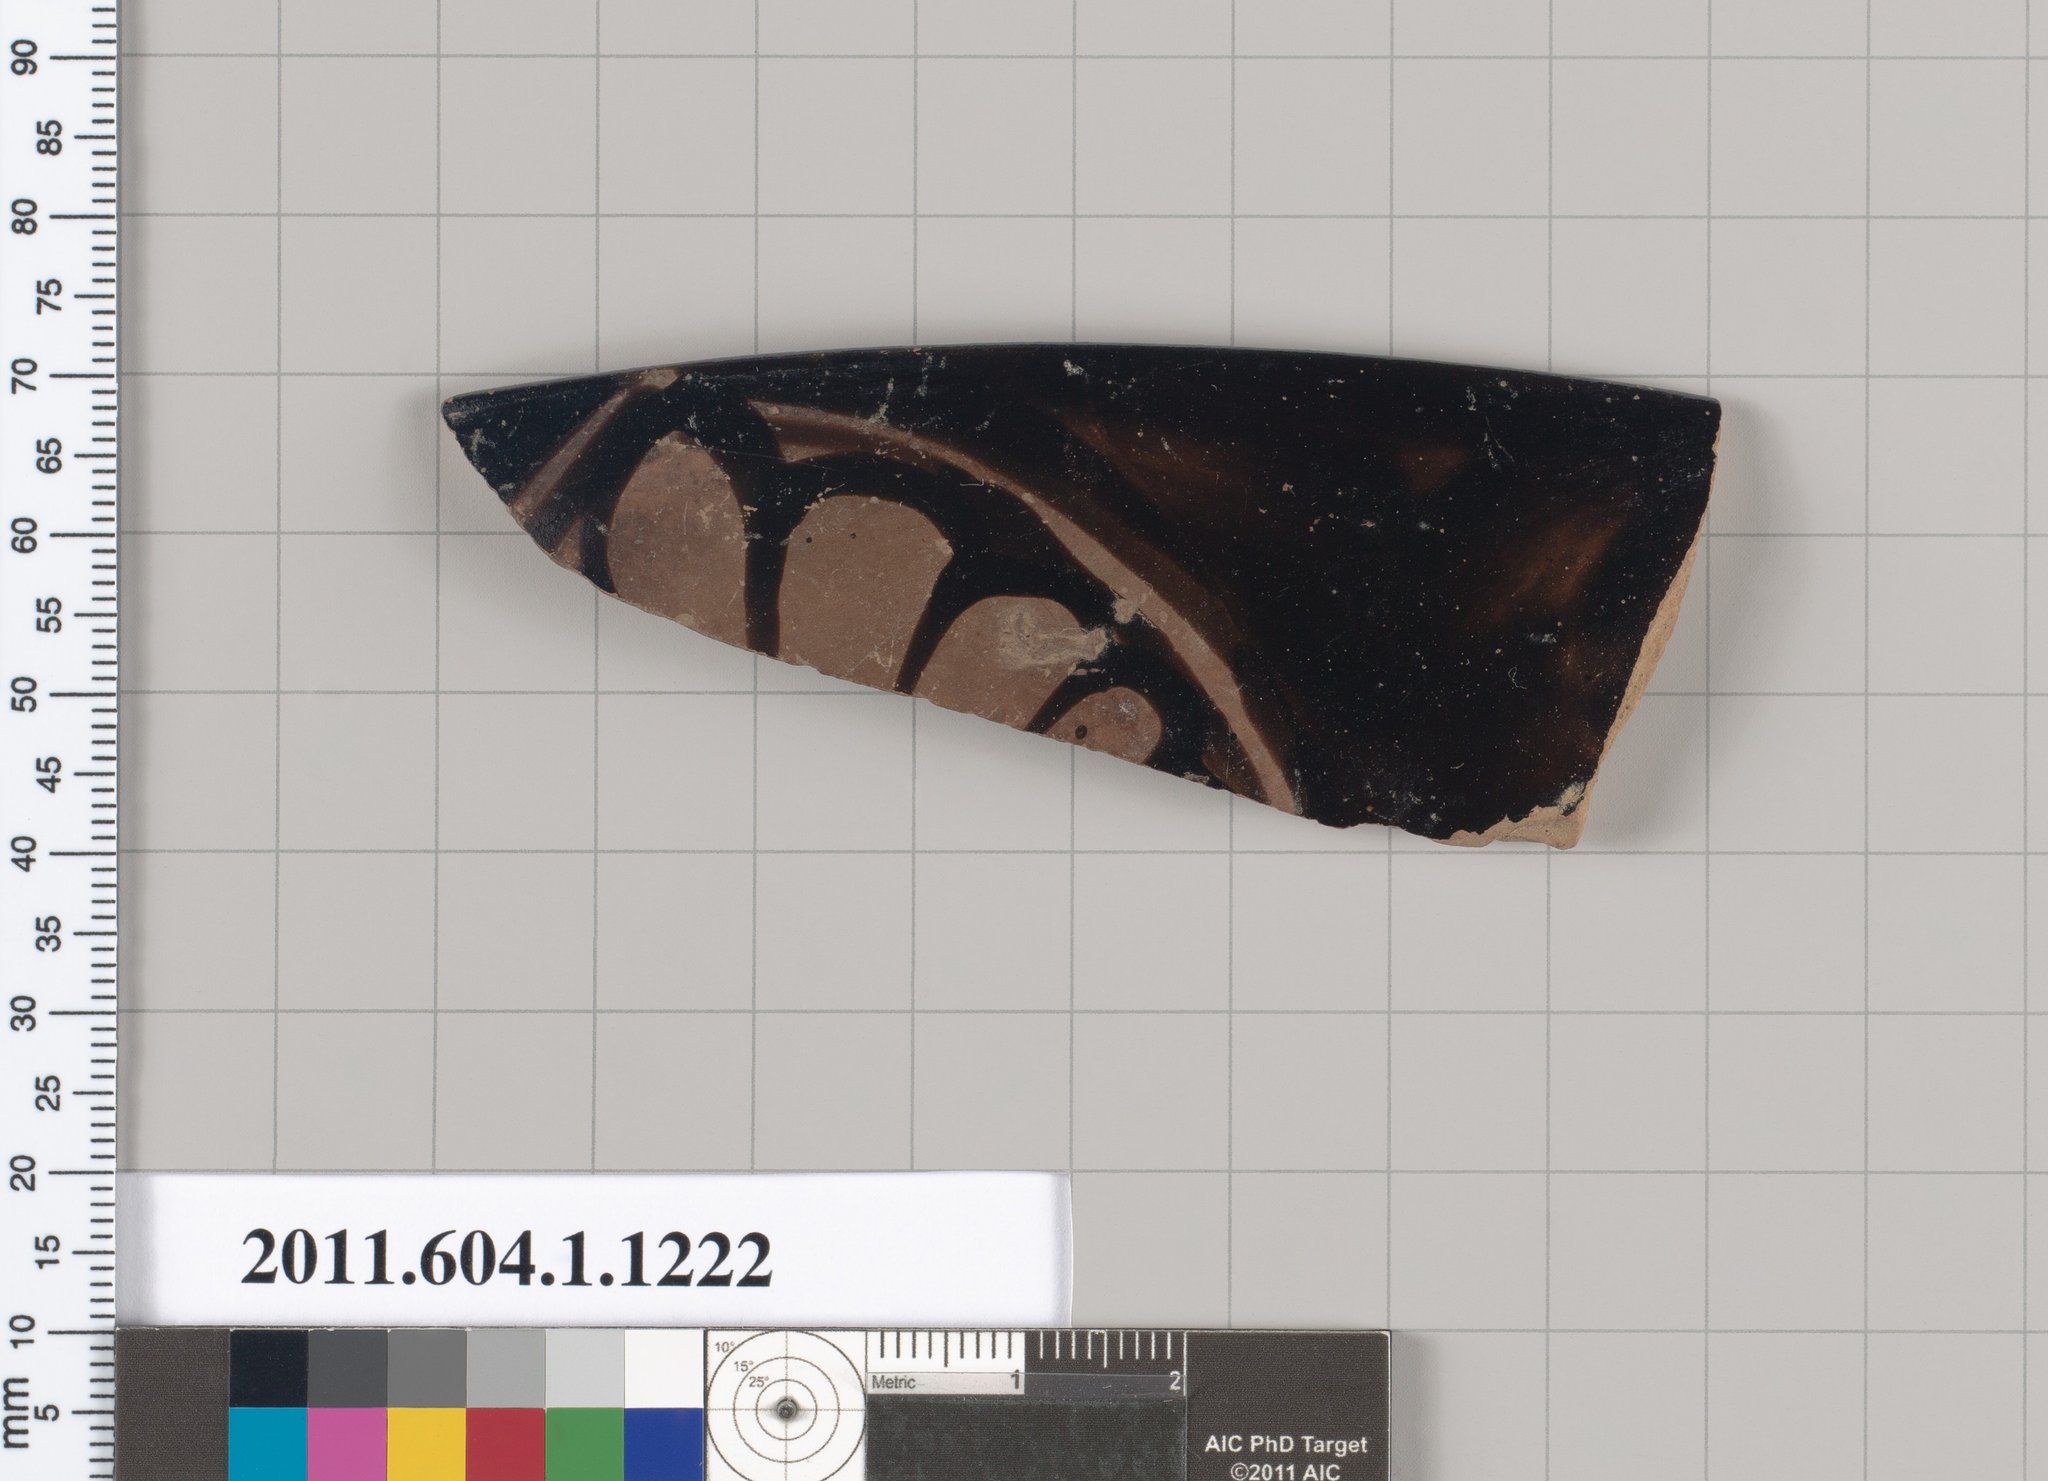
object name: kylix fragment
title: Terracotta fragment of a kylix (drinking cup)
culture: greek, attic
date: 490-480 BCE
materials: terracotta